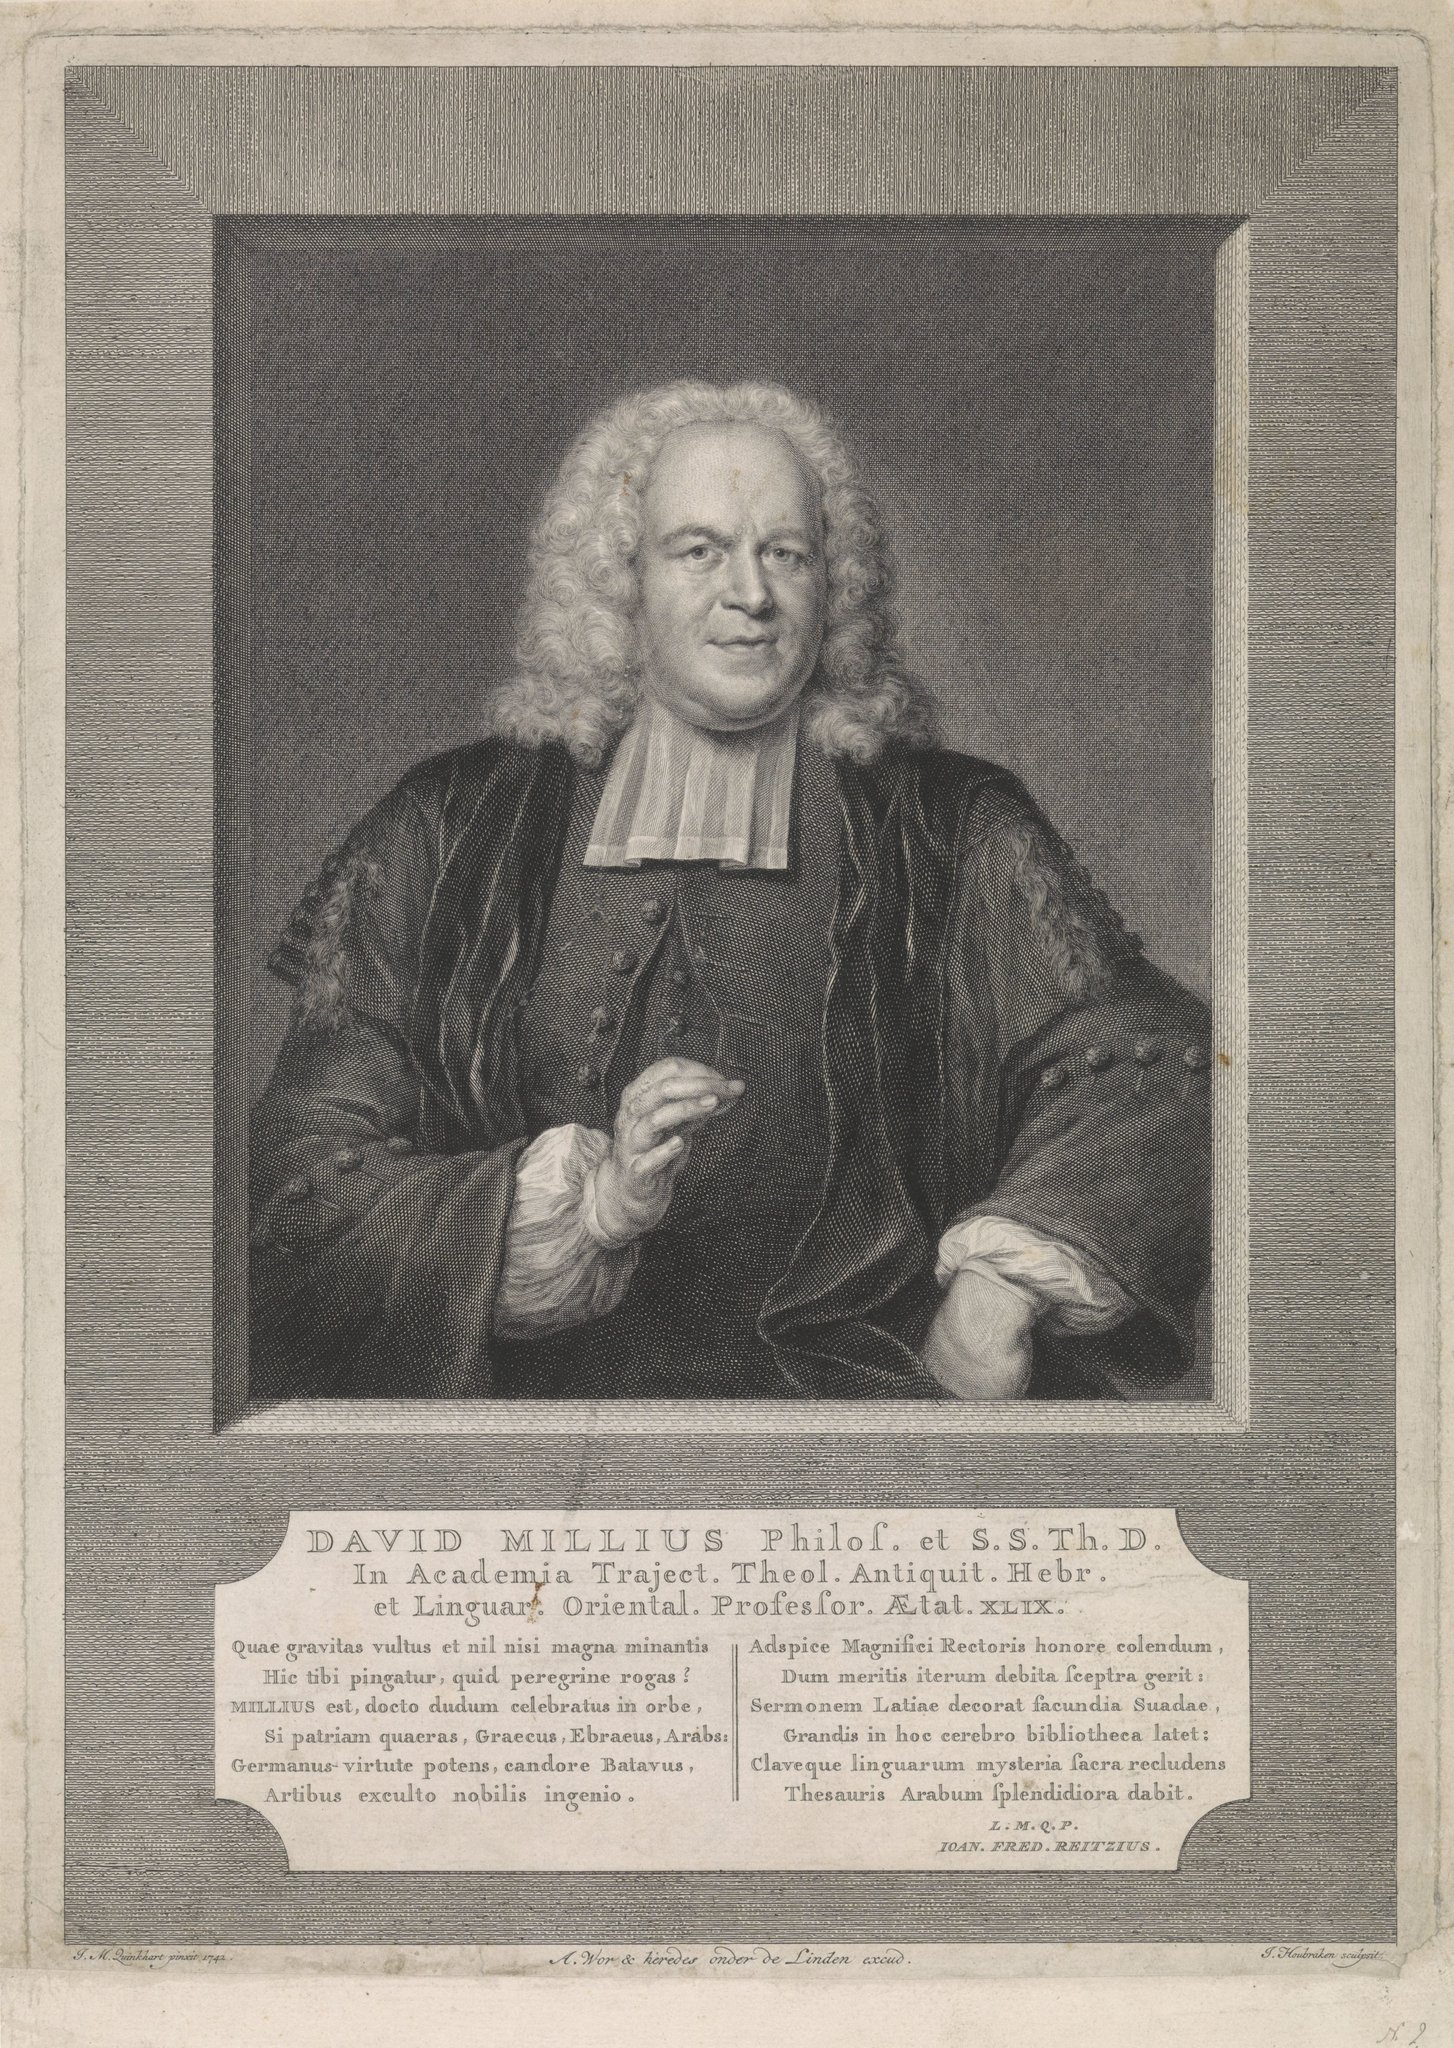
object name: print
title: Portret van David Millius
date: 1742-1750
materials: paper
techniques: engraving, etching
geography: amsterdam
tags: utrecht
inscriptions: collector's mark: Lugt 2228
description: Portret ten halven lijve van David Millius in een rechthoekig venster. Onder het portret zijn naam en gegevens in drie regels in het Latijn een daaronder twee kolommen met elk zes regels in het Latijn.